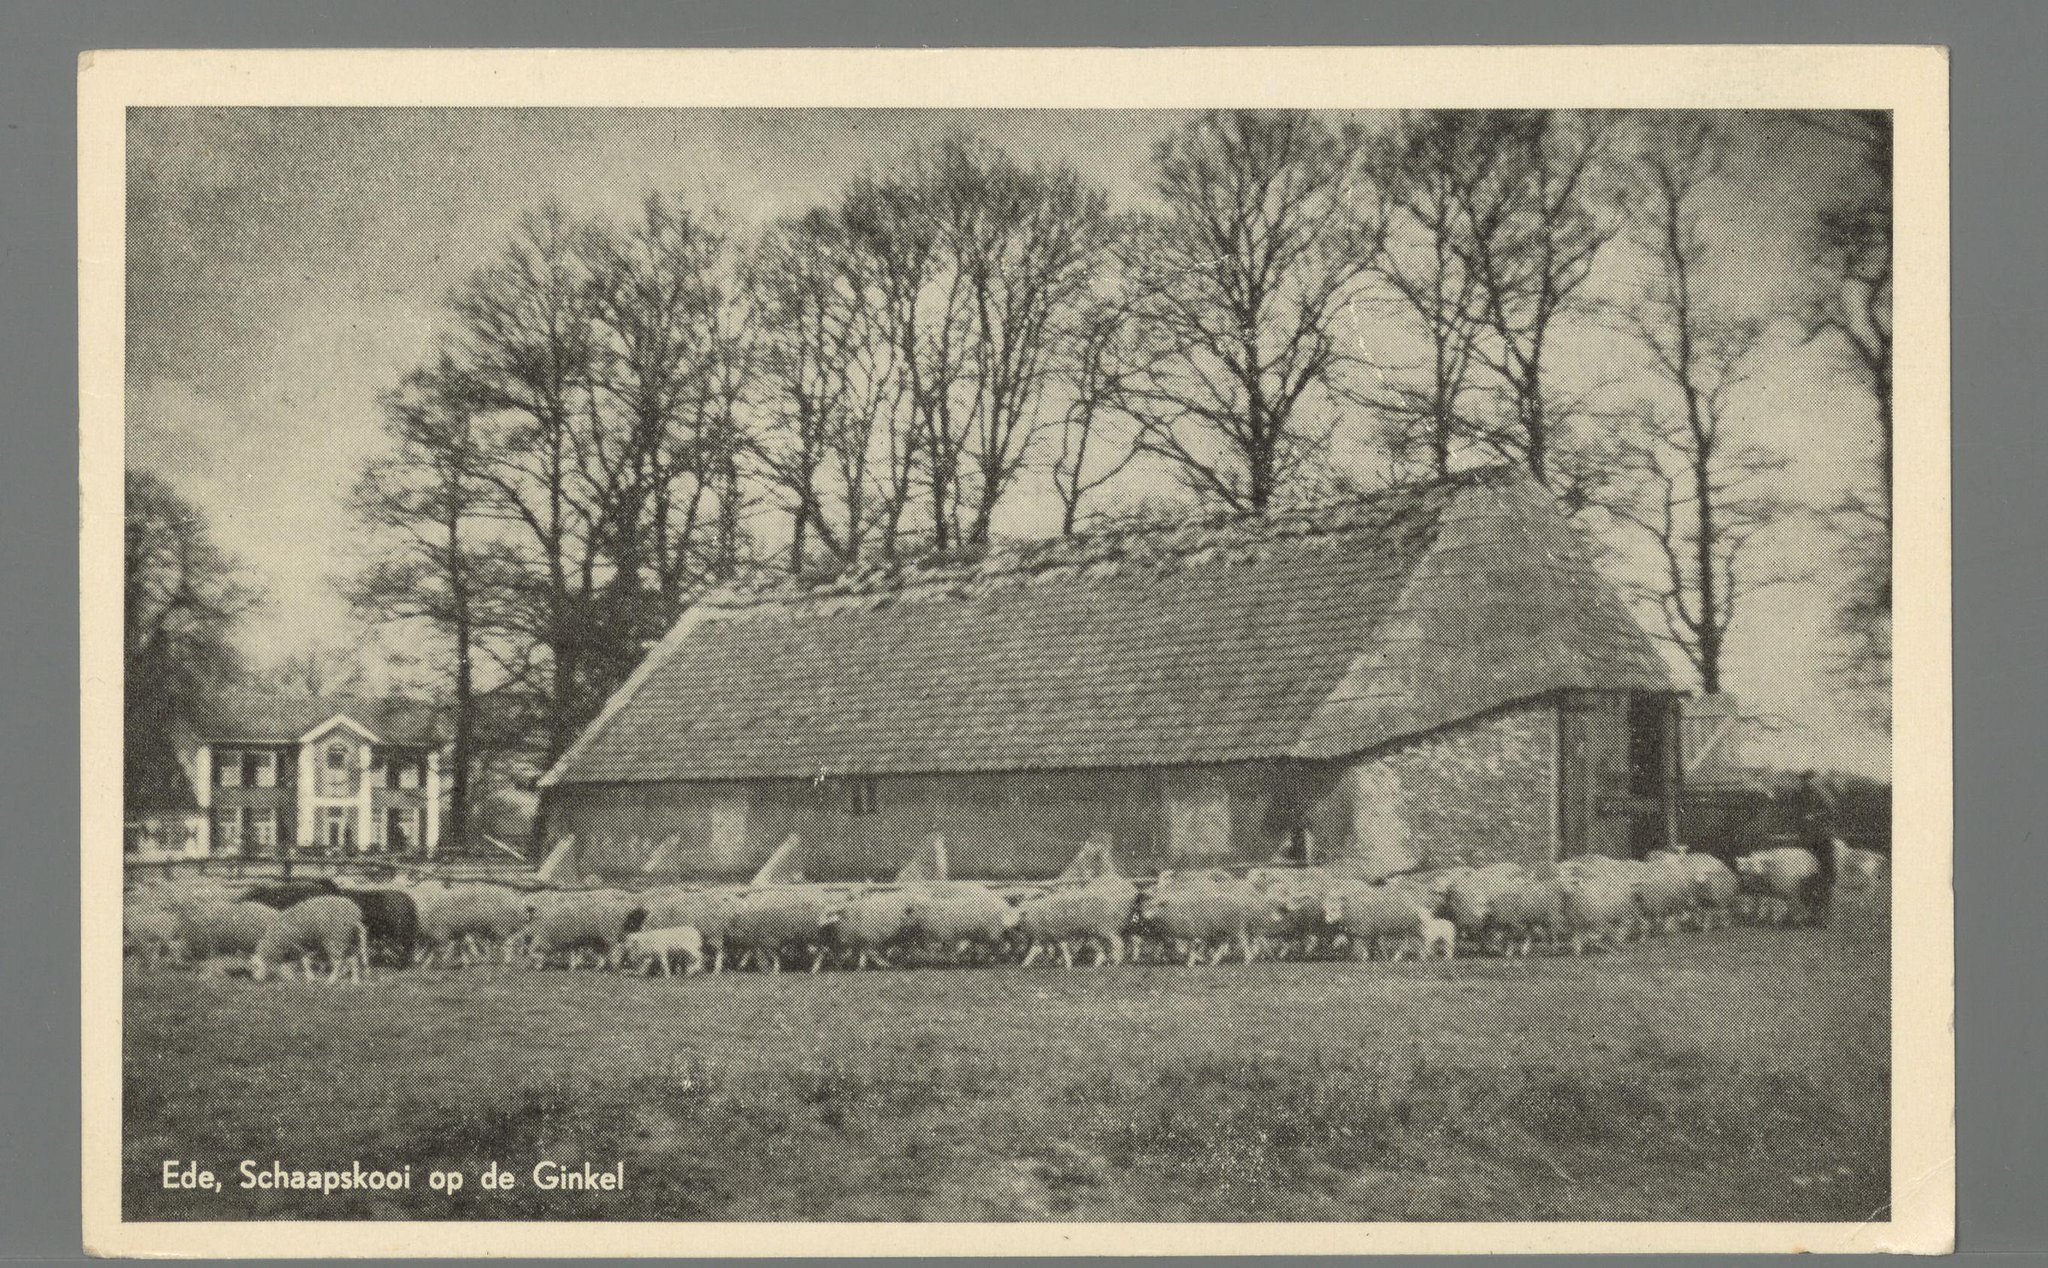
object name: photomechanical print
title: Ede, Schaapskooi op de Ginkel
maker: Anonymous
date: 1931-1954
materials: cardboard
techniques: writing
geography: baarn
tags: farm or solitary house in landscape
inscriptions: postage stamp